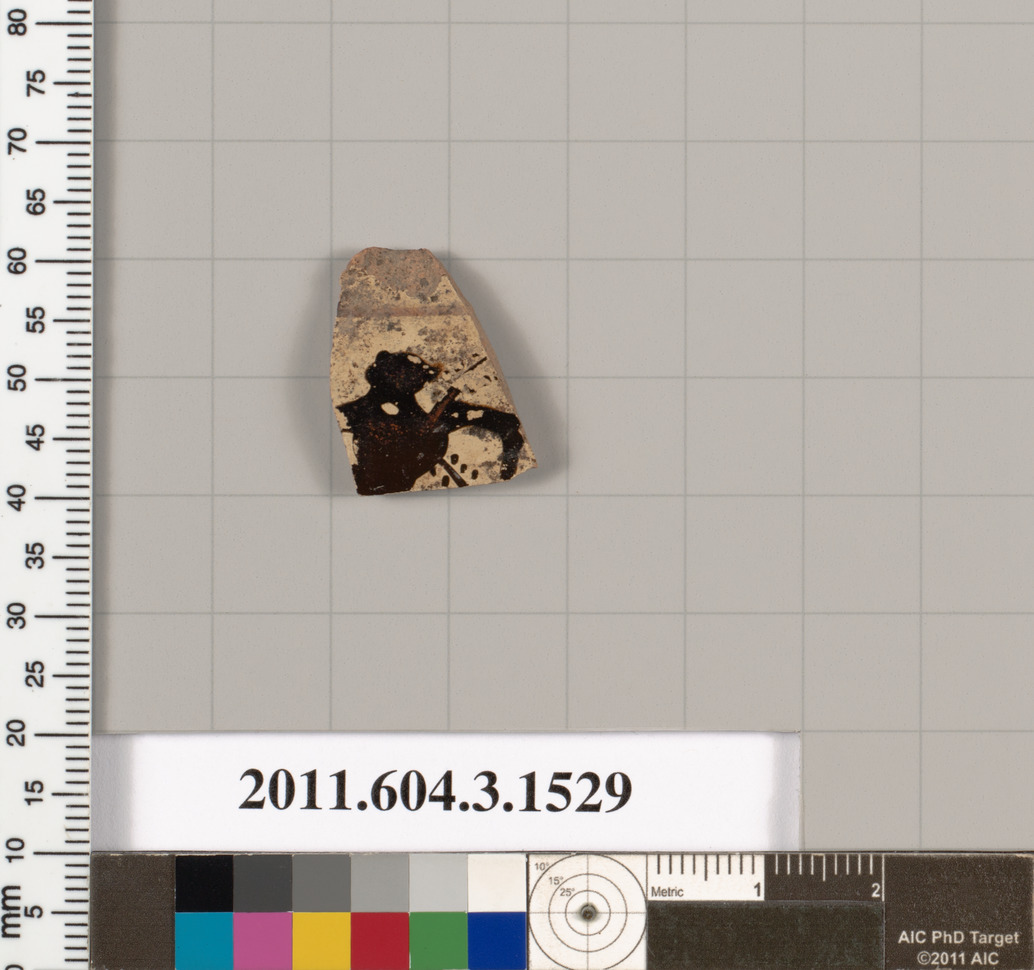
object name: skyphos fragment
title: Terracotta fragment of a skyphos (deep drinking cup)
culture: greek, attic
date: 534-468 BCE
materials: terracotta